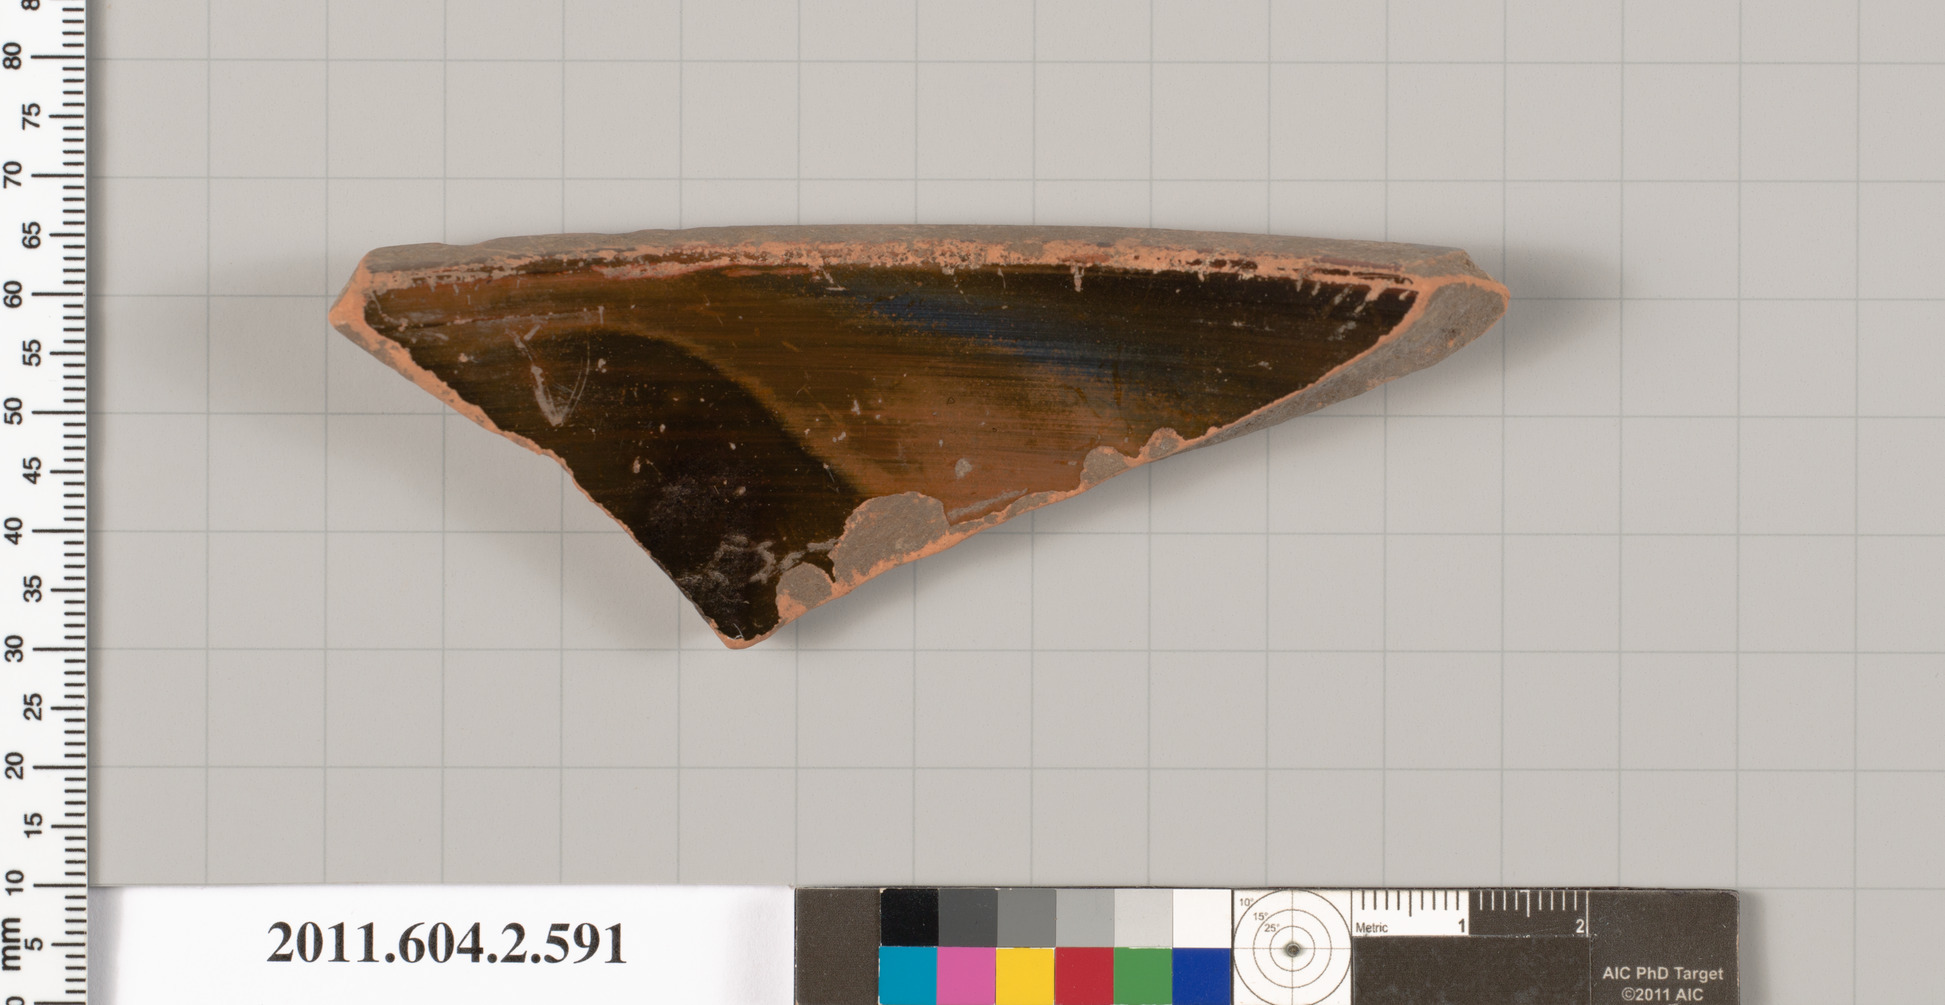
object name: column krater fragment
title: Terracotta fragment of a column-krater (bowl for mixing wine and water)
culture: greek, attic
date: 470-440 BCE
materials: terracotta